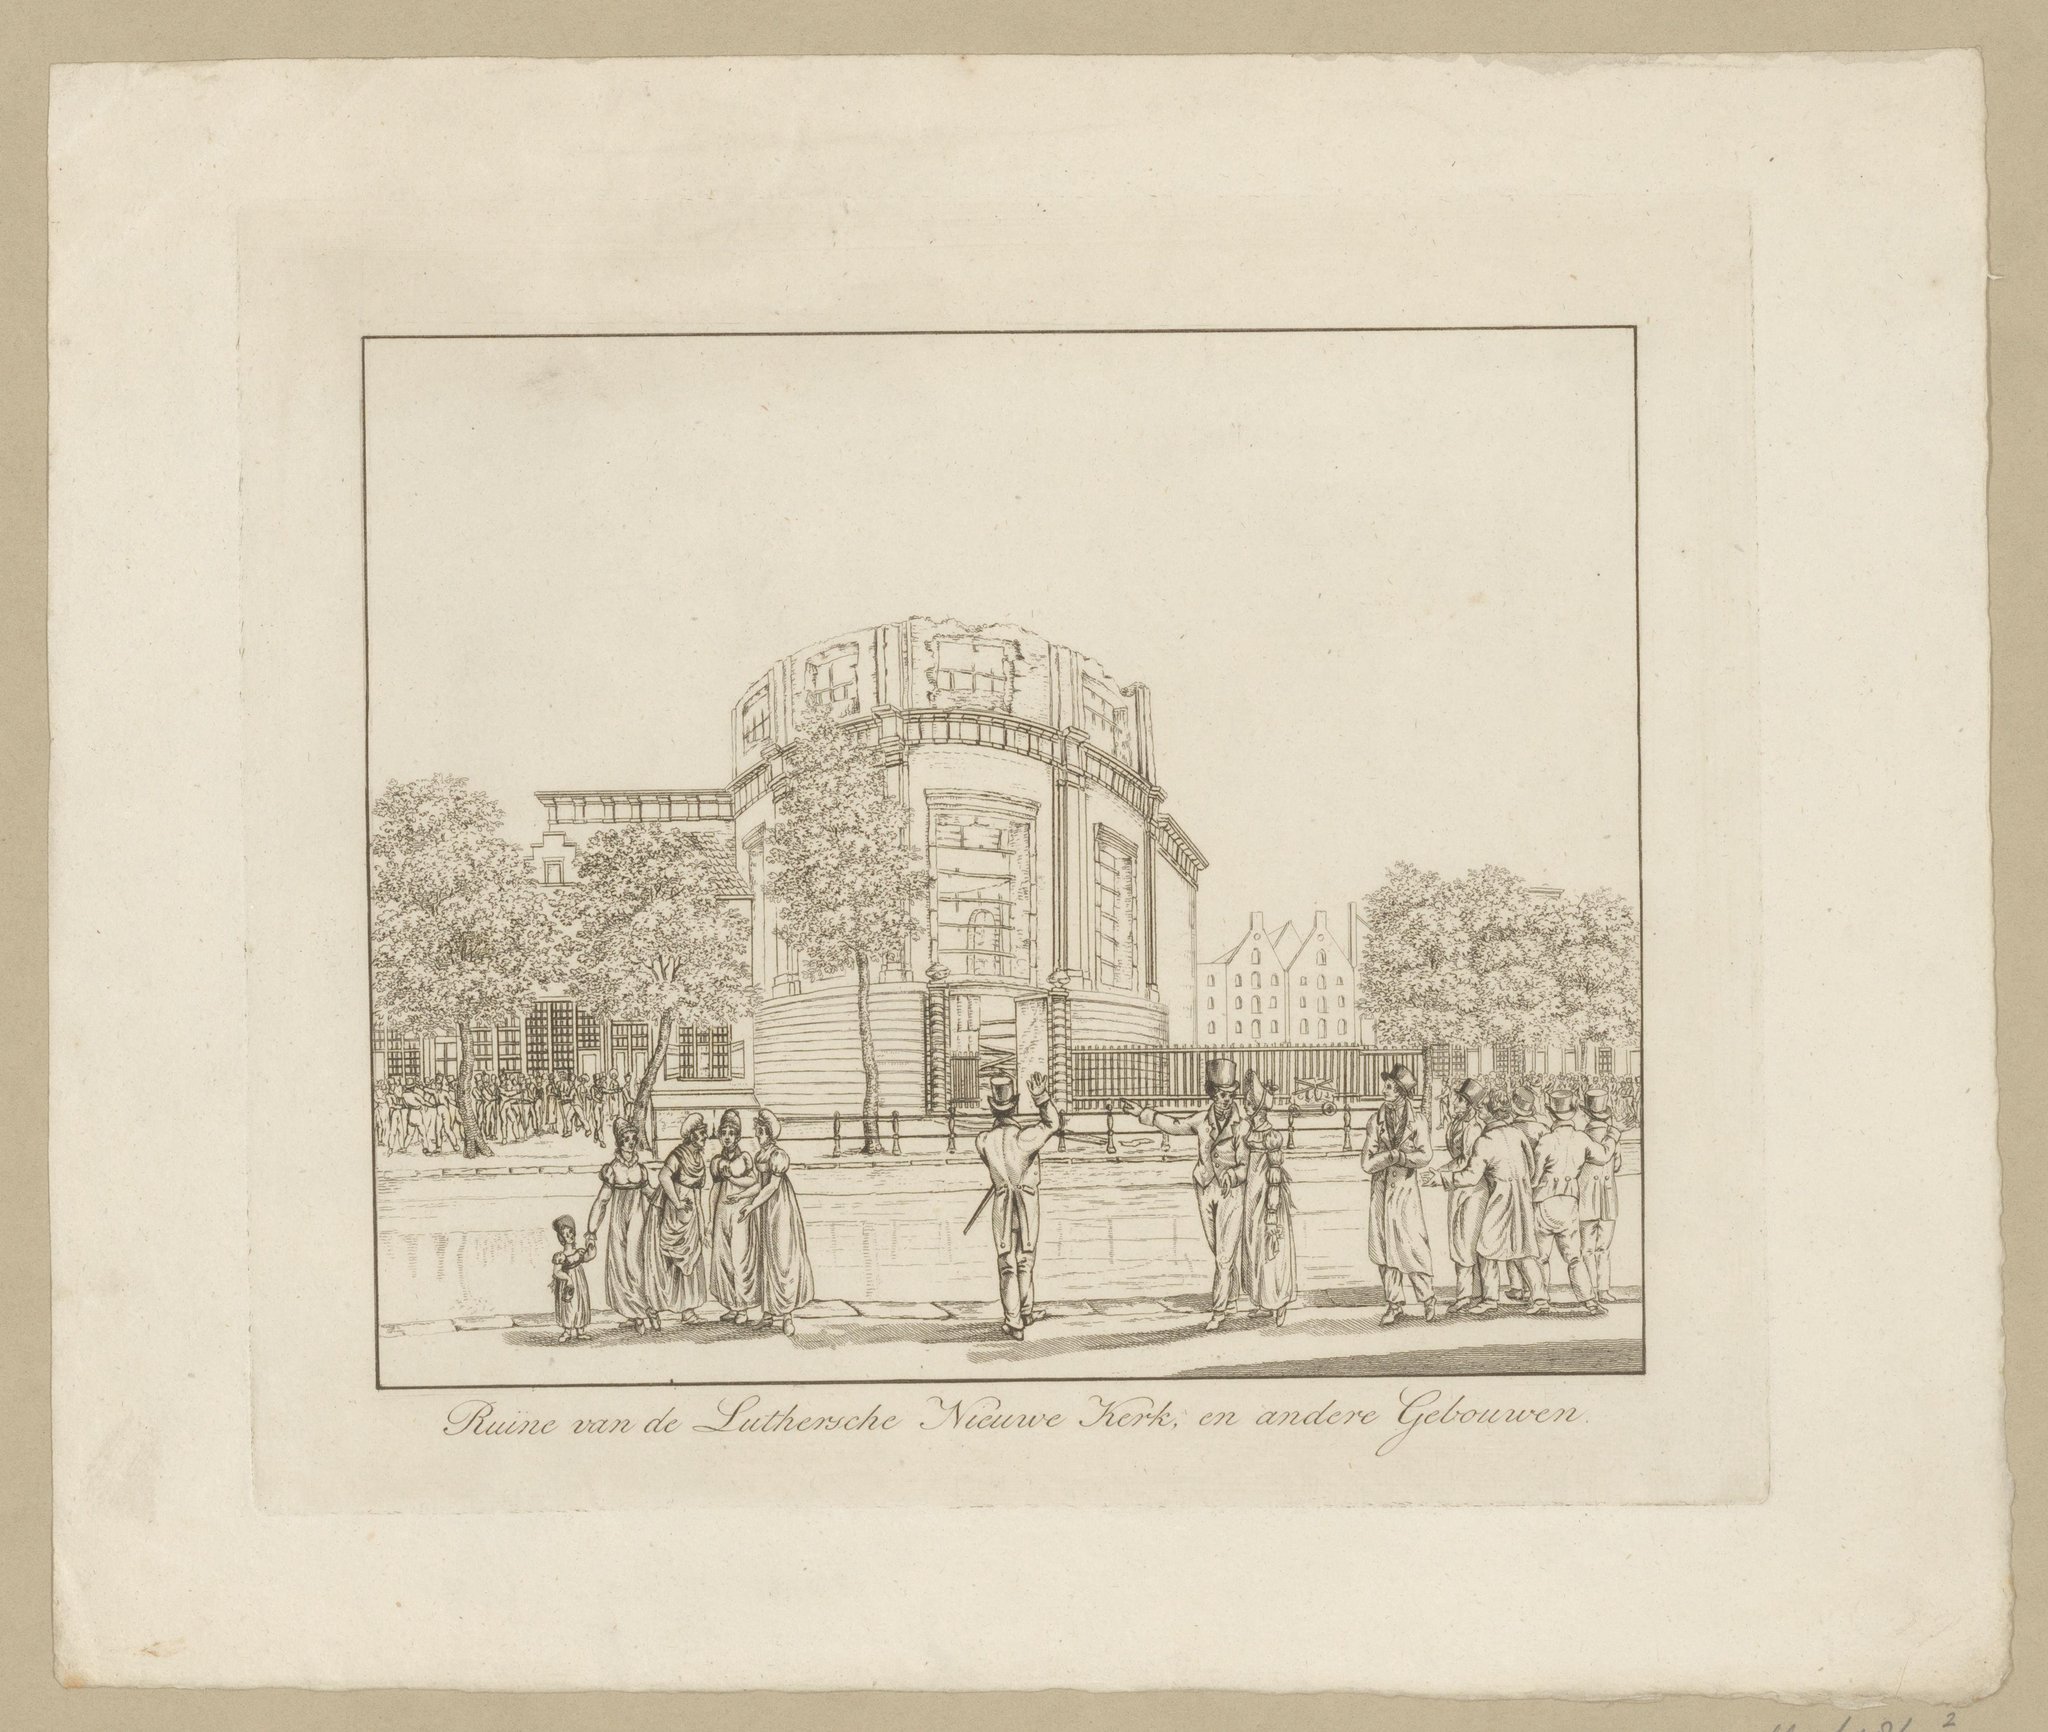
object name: print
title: Ruine van de Luthersche Nieuwe Kerk, en andere Gebouwen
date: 1822-1823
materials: paper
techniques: engraving, etching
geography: amsterdam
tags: ruin of a building ~ architecture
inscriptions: collector's mark: Lugt 1641b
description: Ruïne van de Nieuwe Lutherse Kerk op het Singel te Amsterdam, na de brand op 18 september 1822. Op de voorgrond publiek aan de overzijde van het Singel. Illustratie in een uitgave uit 1823 over de brand. Onderwerpsrubriek binnen de Atlas Amsterdam: Kerkwezen: Ev. Lutherse Gemeente: 1822 Brand in de Nieuwe Luthersche Koepelkerk - Ruïne.